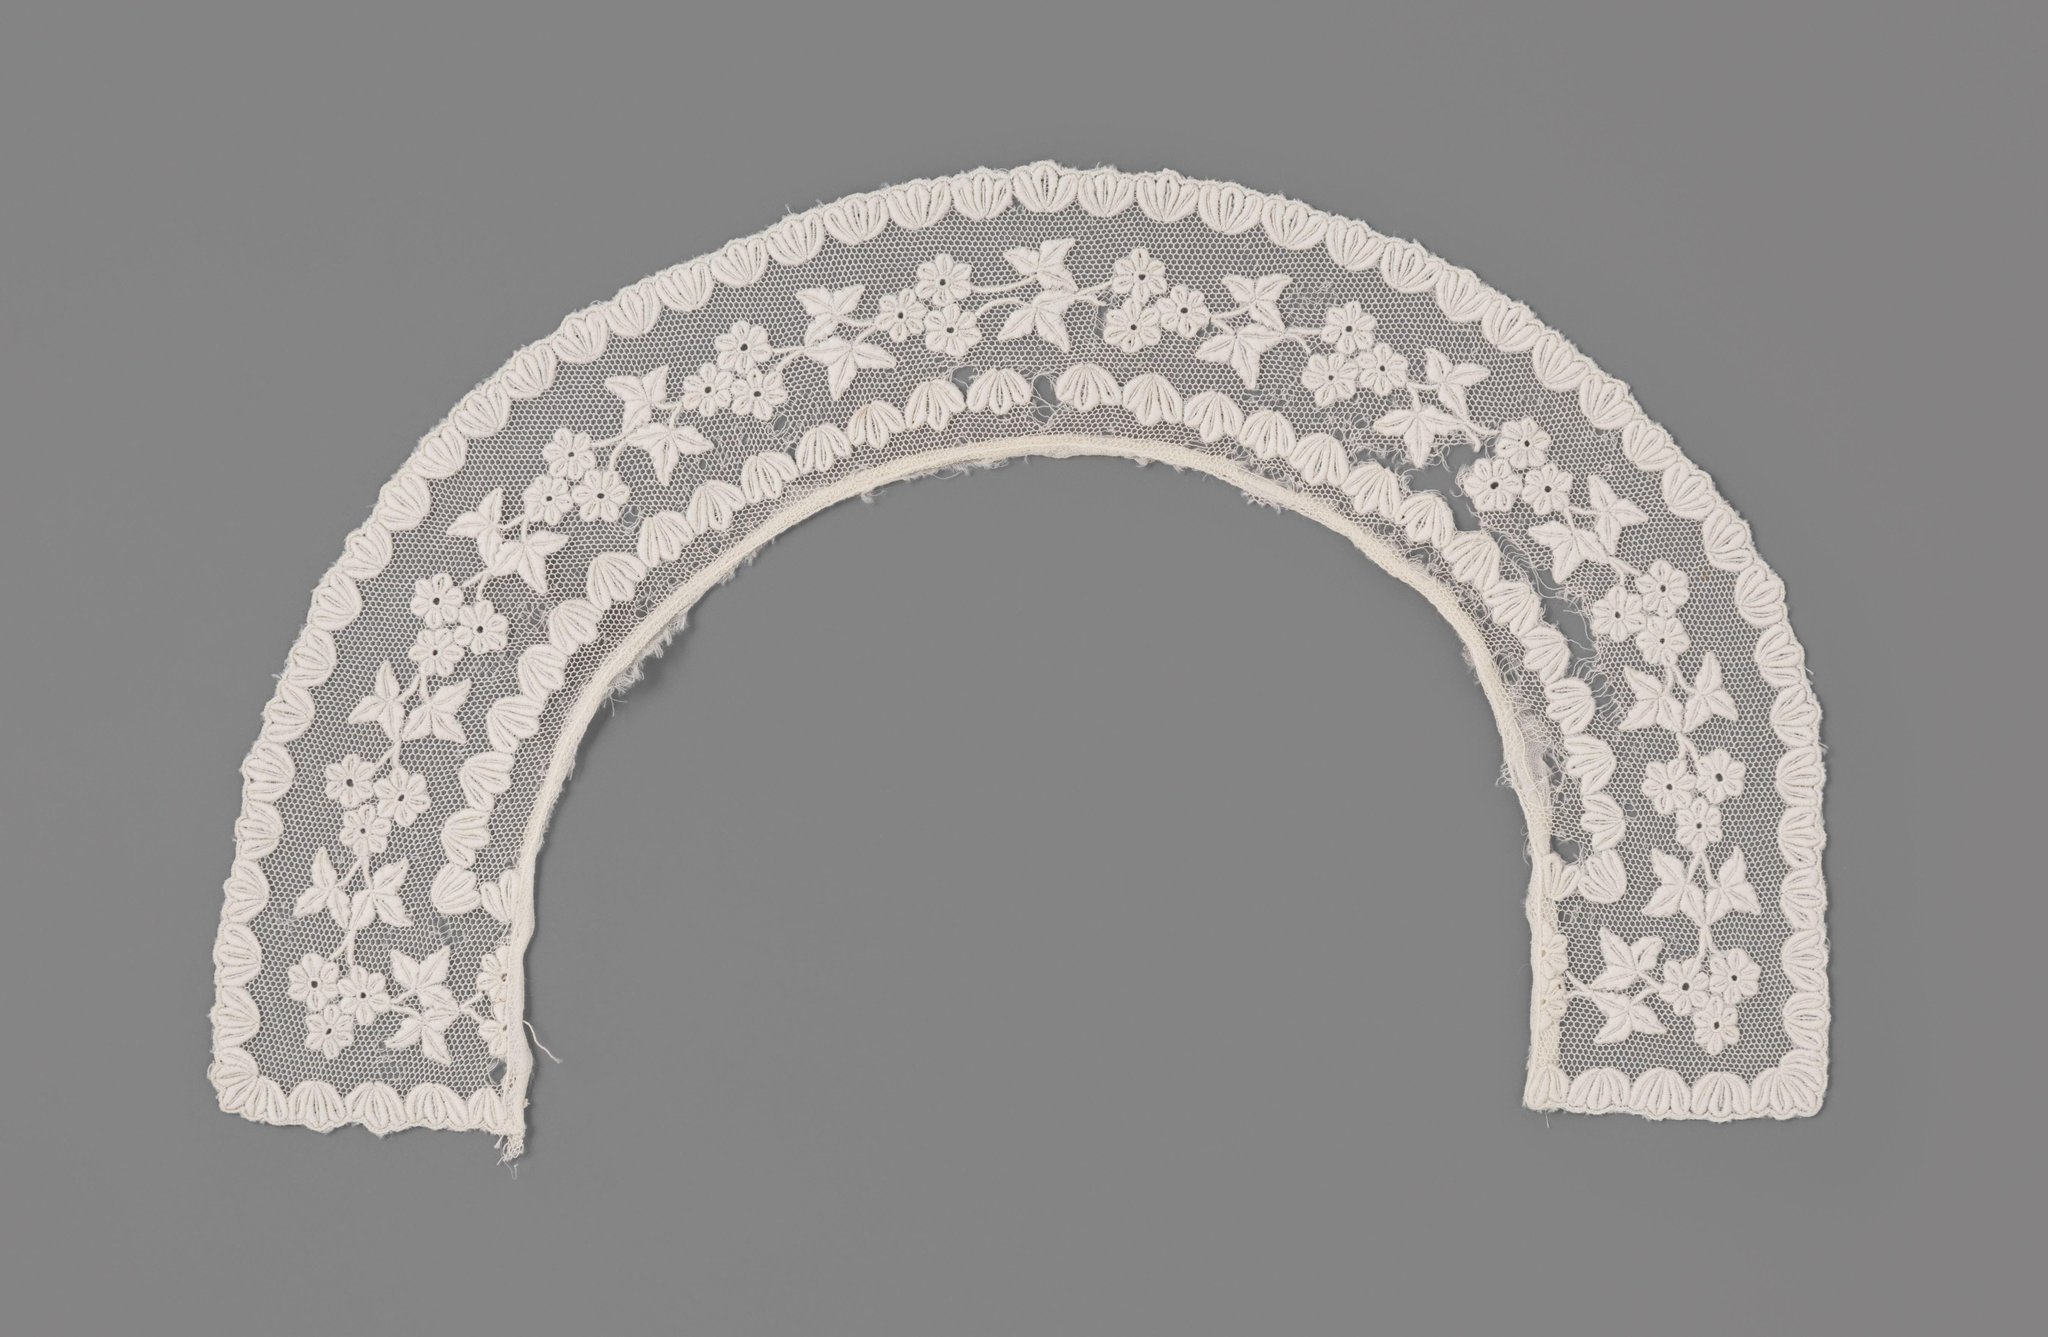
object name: collar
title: Ronde kraag van tule met witwerk (plumetis) in de vorm van bladeren en bloemen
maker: Anonymous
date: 1850-1875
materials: fiber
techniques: embroidery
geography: western europe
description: Kraag van tule met plumetis borduurwerk. Binnen lijsten van aaneengesloten driebladeren loopt een rank met telkens drie bloemen en bladeren.